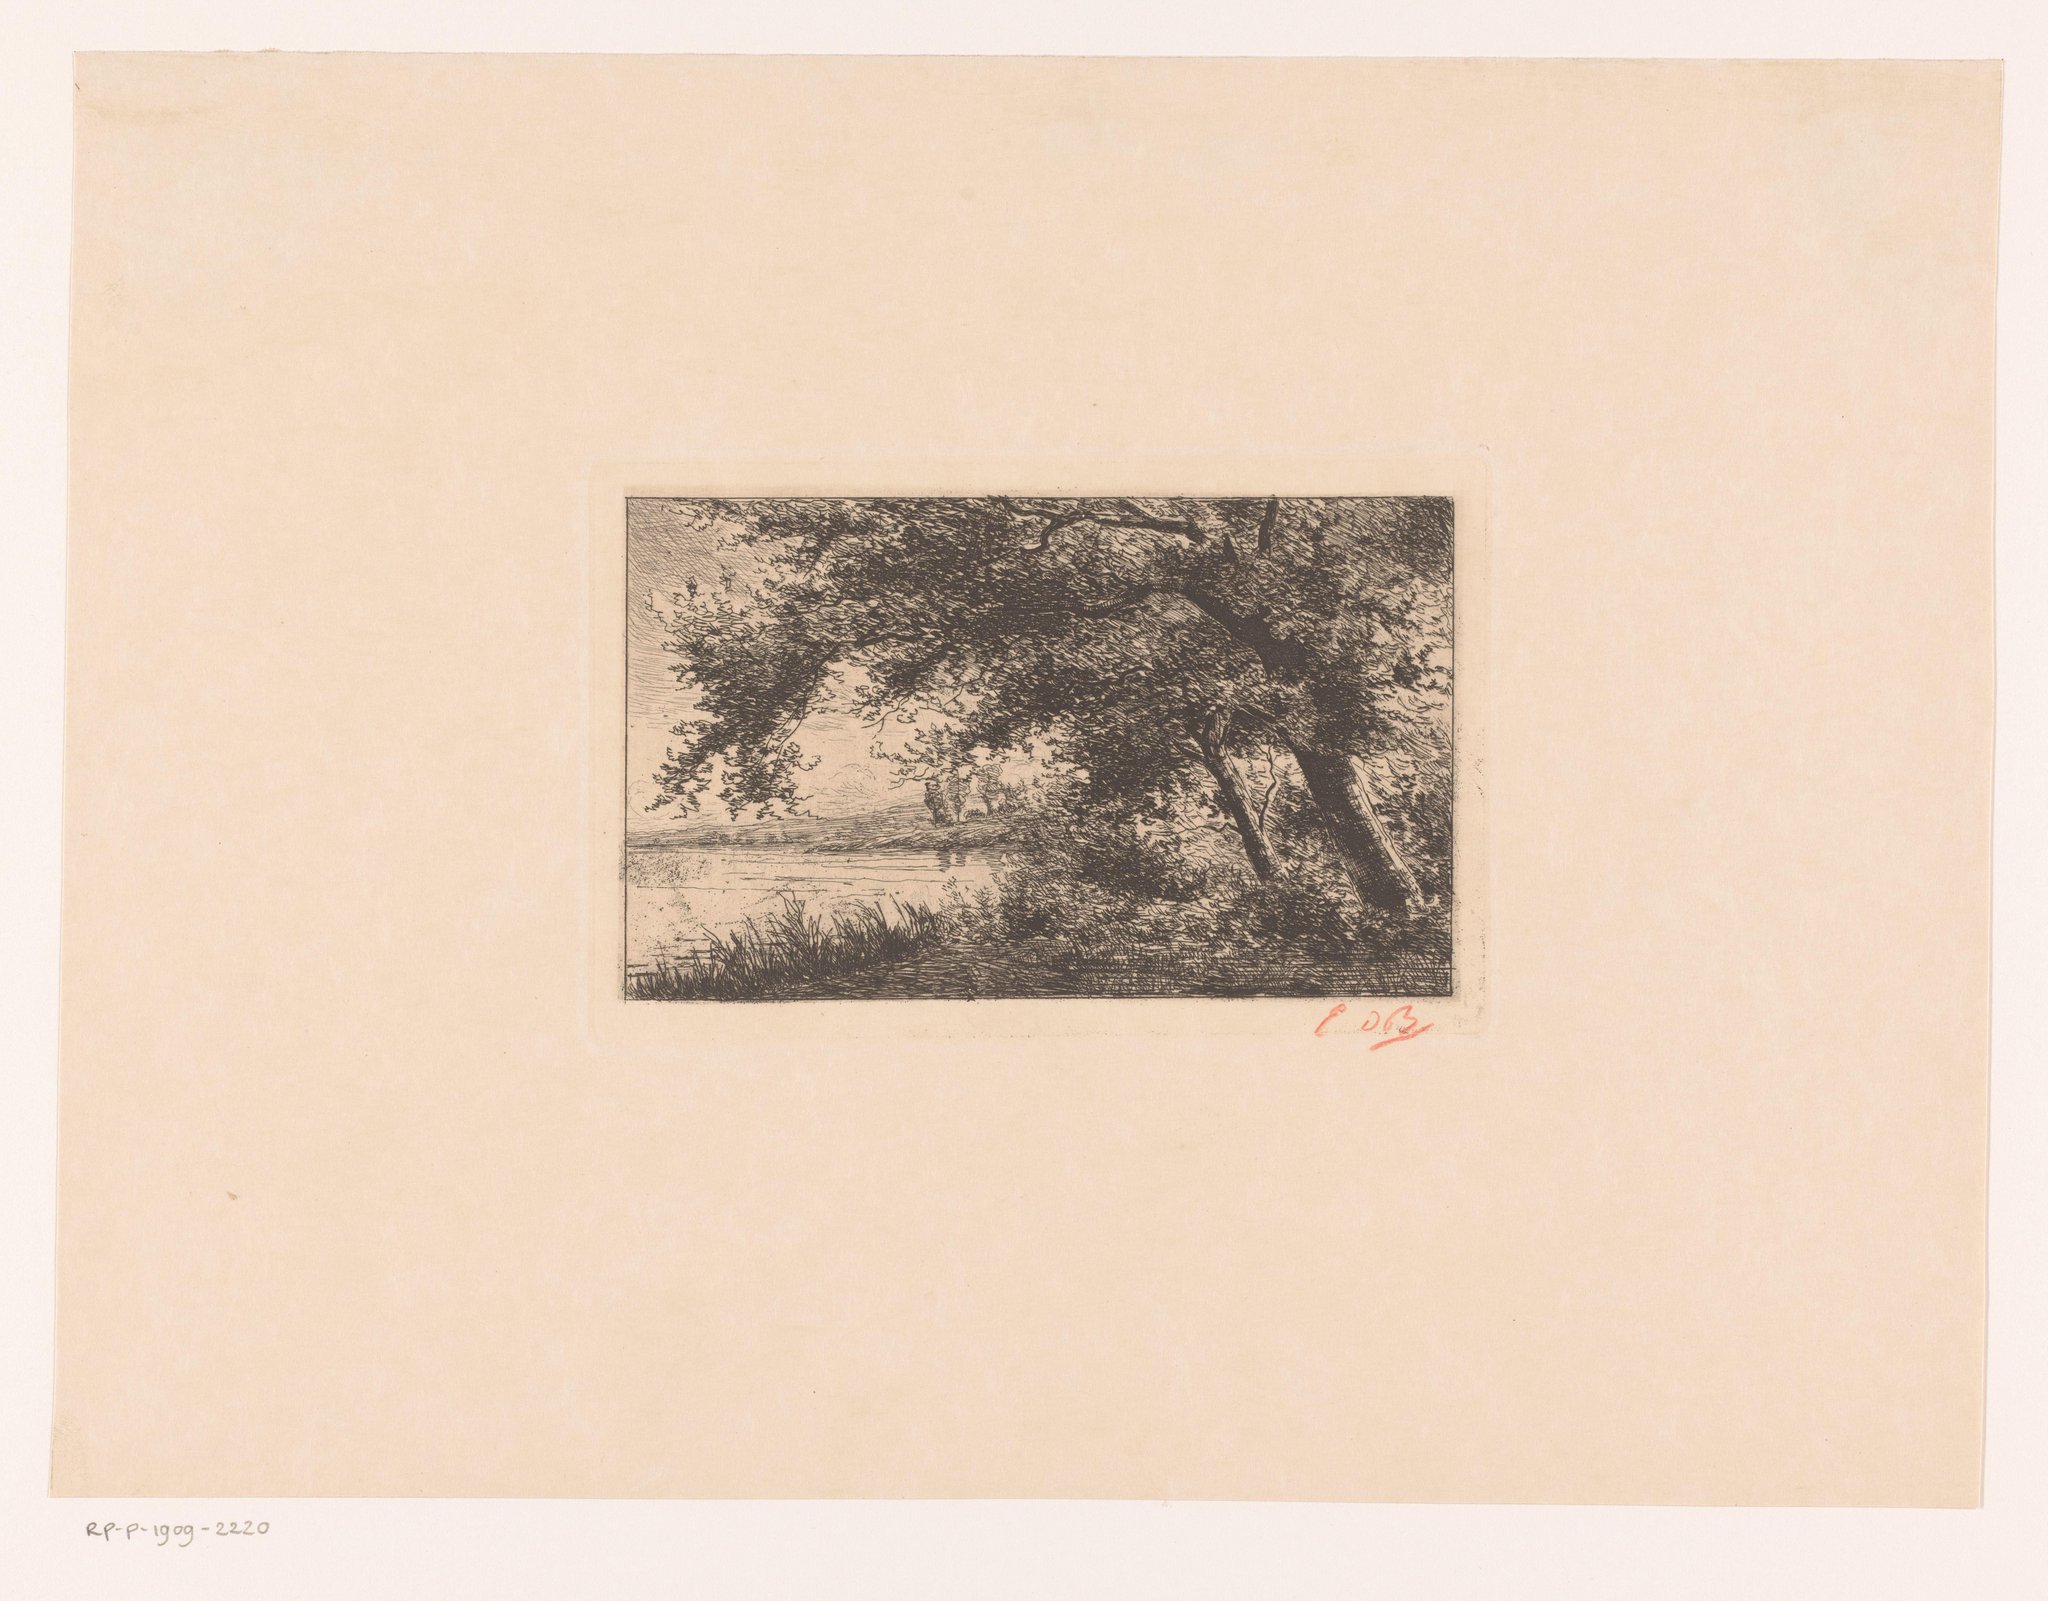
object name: print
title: Bomen aan de waterkant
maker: emile de baré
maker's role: painter, print maker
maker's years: 1855-1902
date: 1865-1902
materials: paper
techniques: etching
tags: plants; vegetation, lake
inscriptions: collector's mark: Lugt 2228